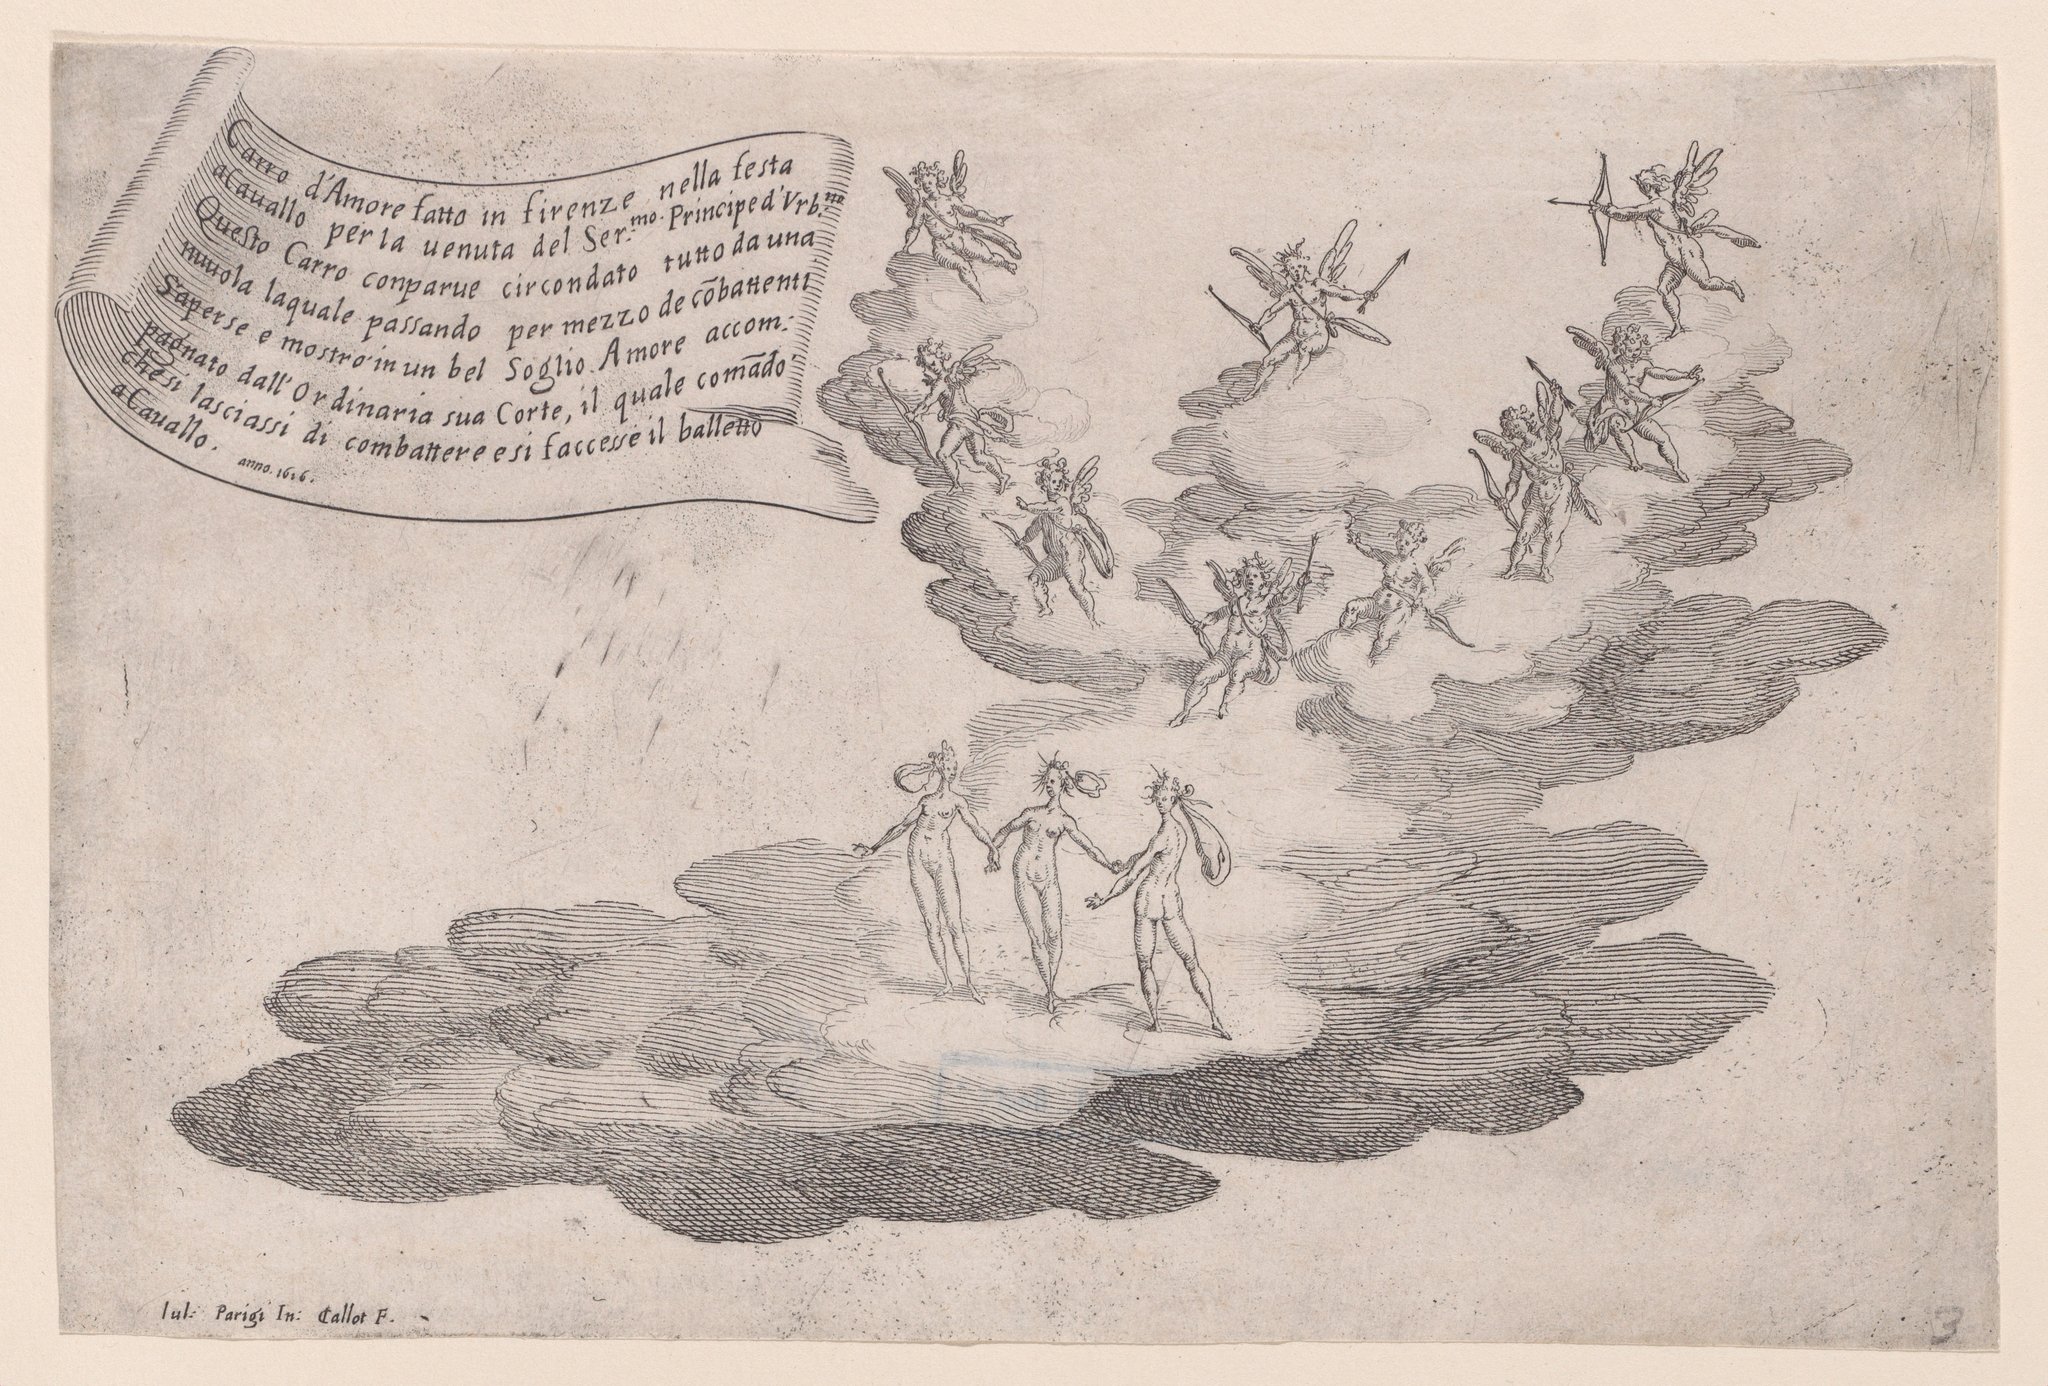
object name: print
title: Le Char de L'Amour, from "Guerre de Beauté" (Guerra di Bellezza) (War of Beauty)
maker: jacques callot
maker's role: artist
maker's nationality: french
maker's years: 1592-1635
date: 1616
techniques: etching